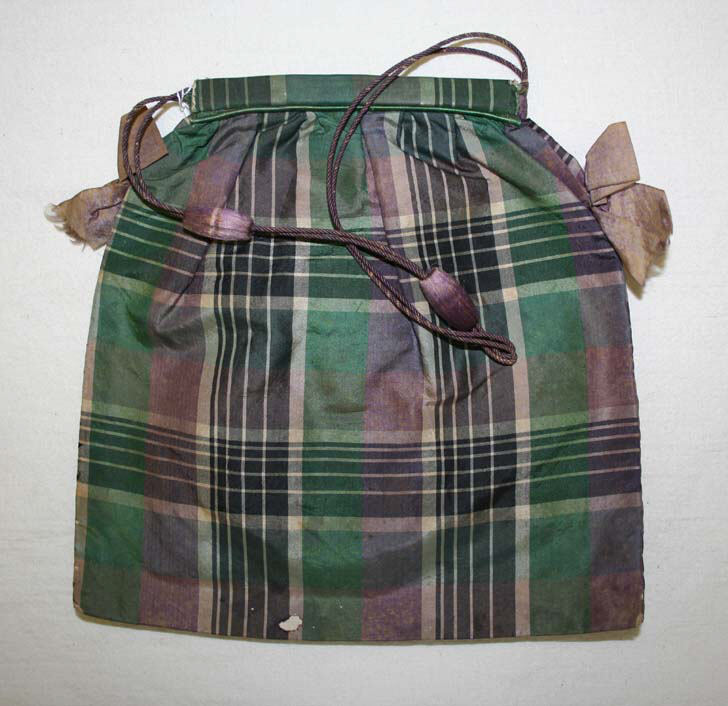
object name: bag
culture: european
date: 1850